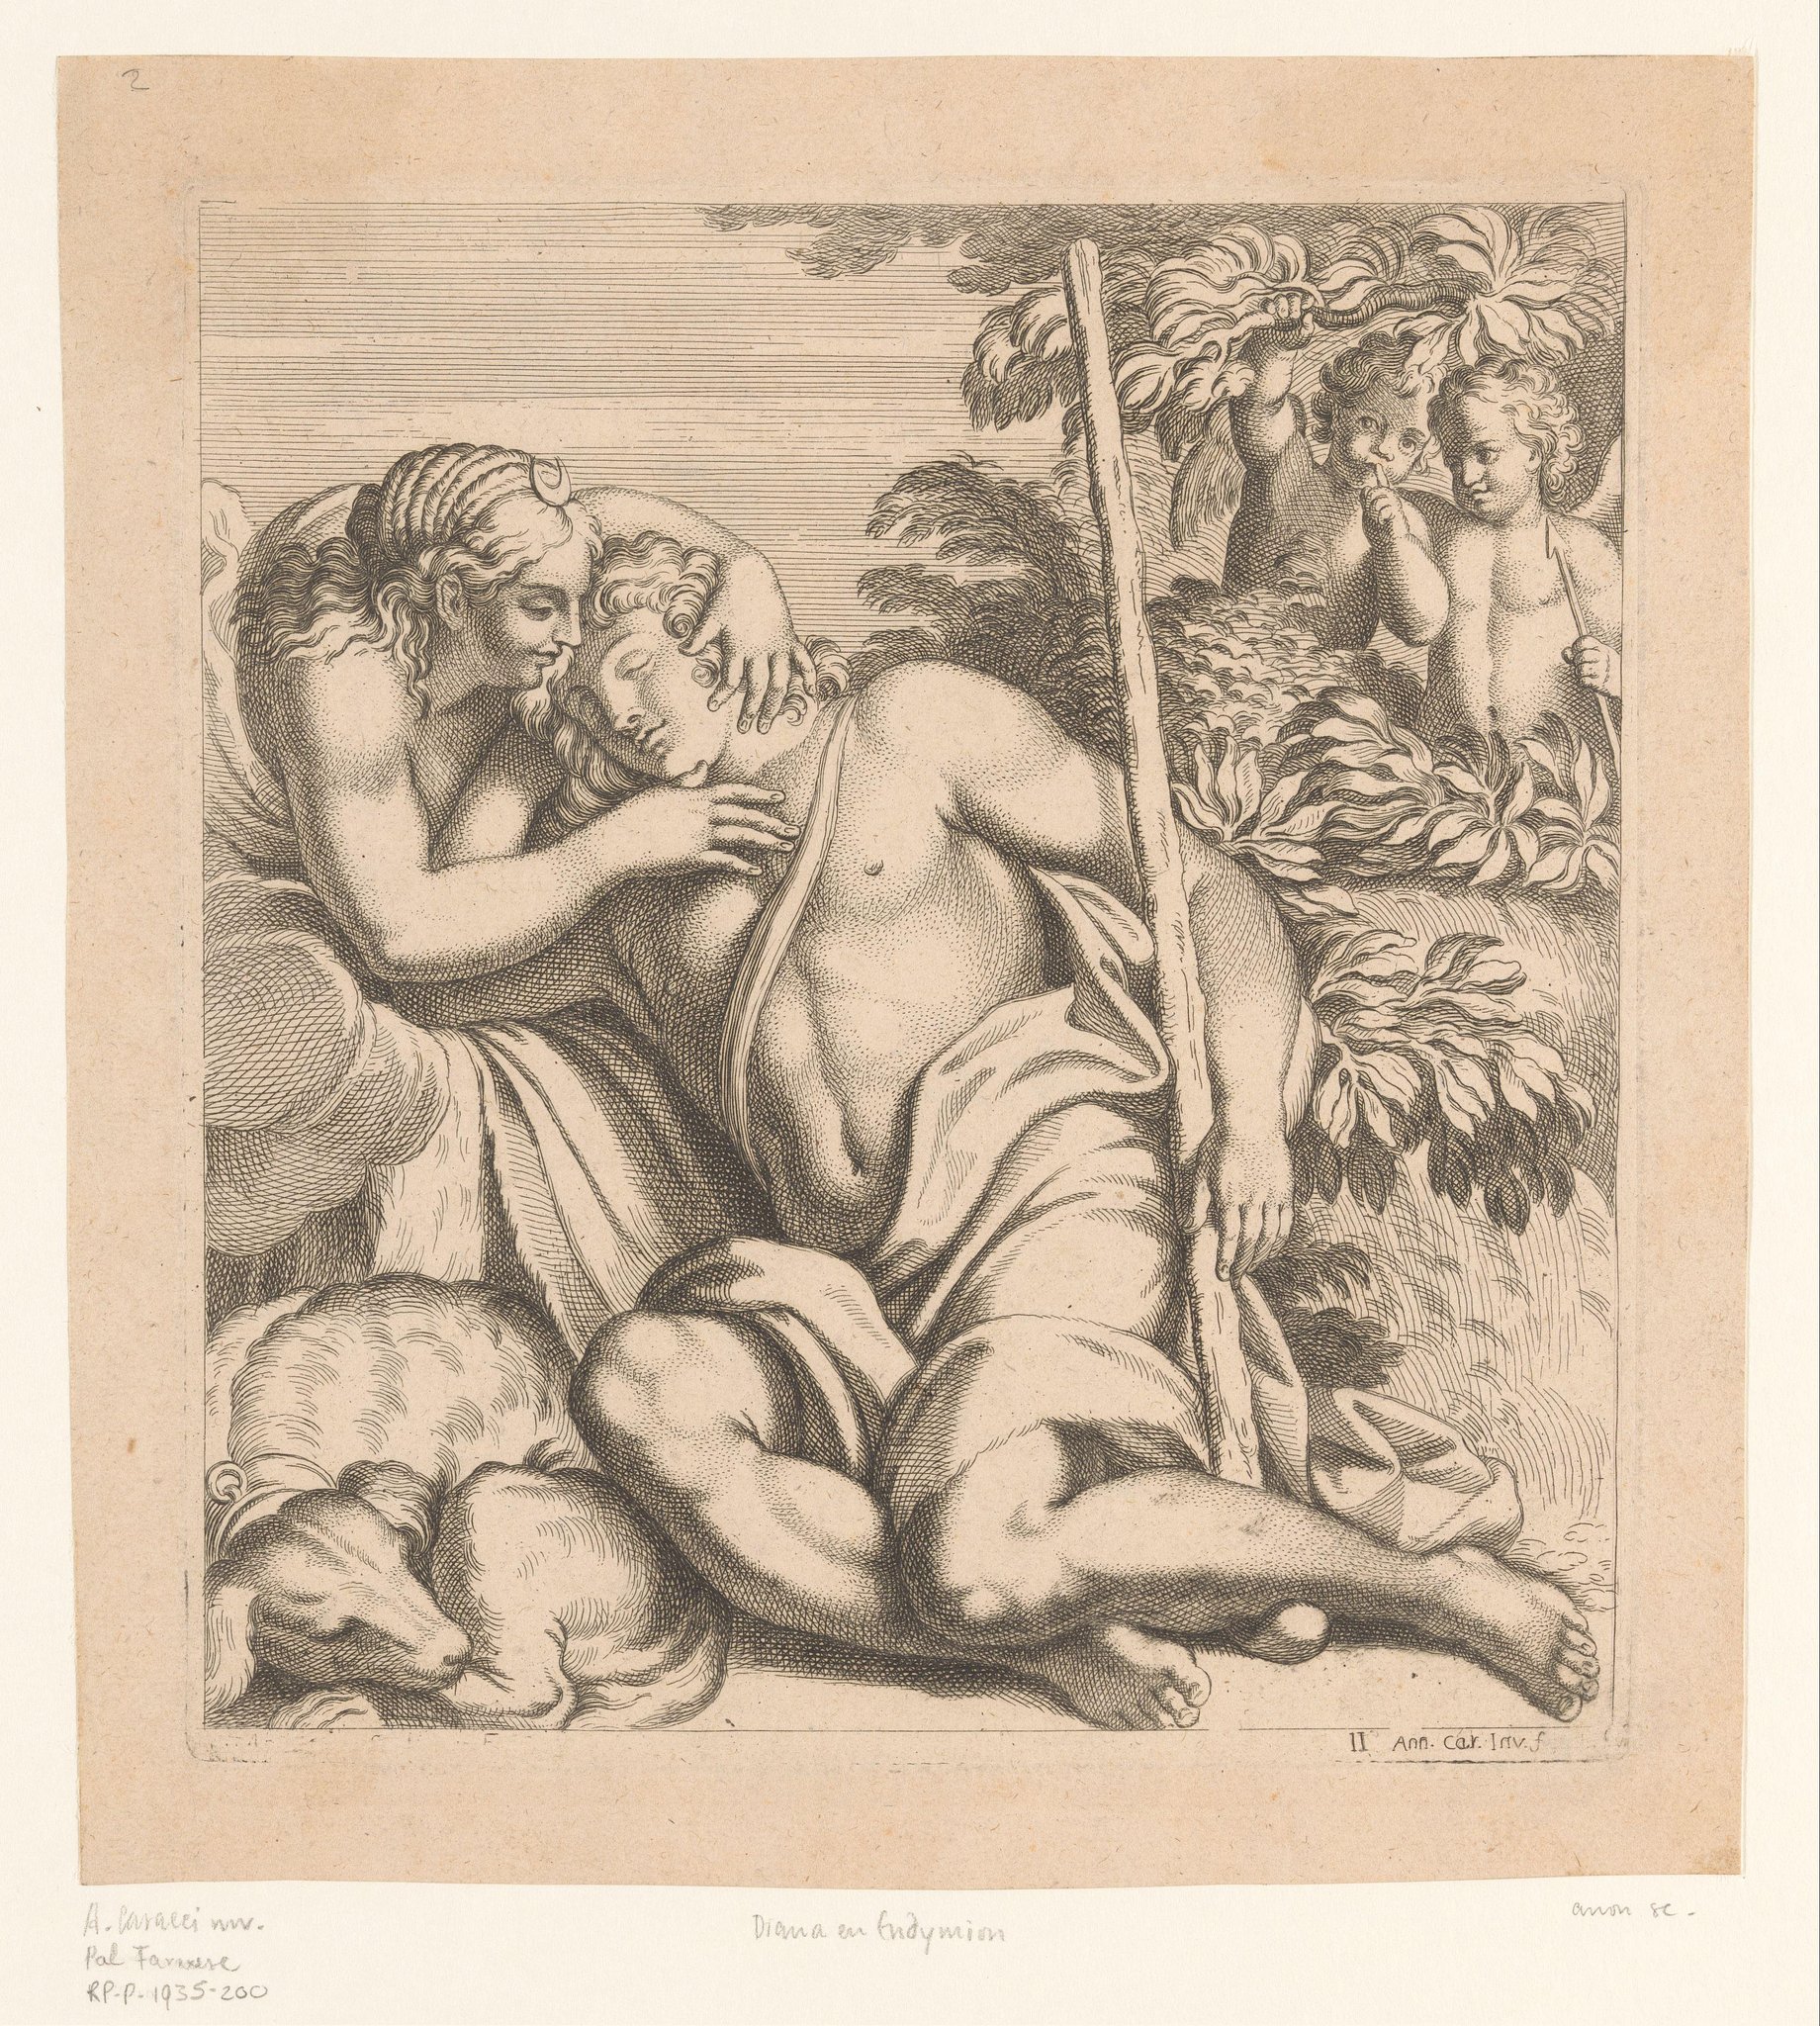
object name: print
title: Schilderingen in Palazzo Farnese te Rome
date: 1570-1659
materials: paper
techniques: etching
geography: rome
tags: hercules wooing iole, (story of) cupid, amor (eros)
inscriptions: collector's mark: Lugt 2228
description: De godin Diana omarmt de eeuwig slapende jongeling Endymion. Op de voorgrond slaapt een hond. Op de achtergrond twee putti.